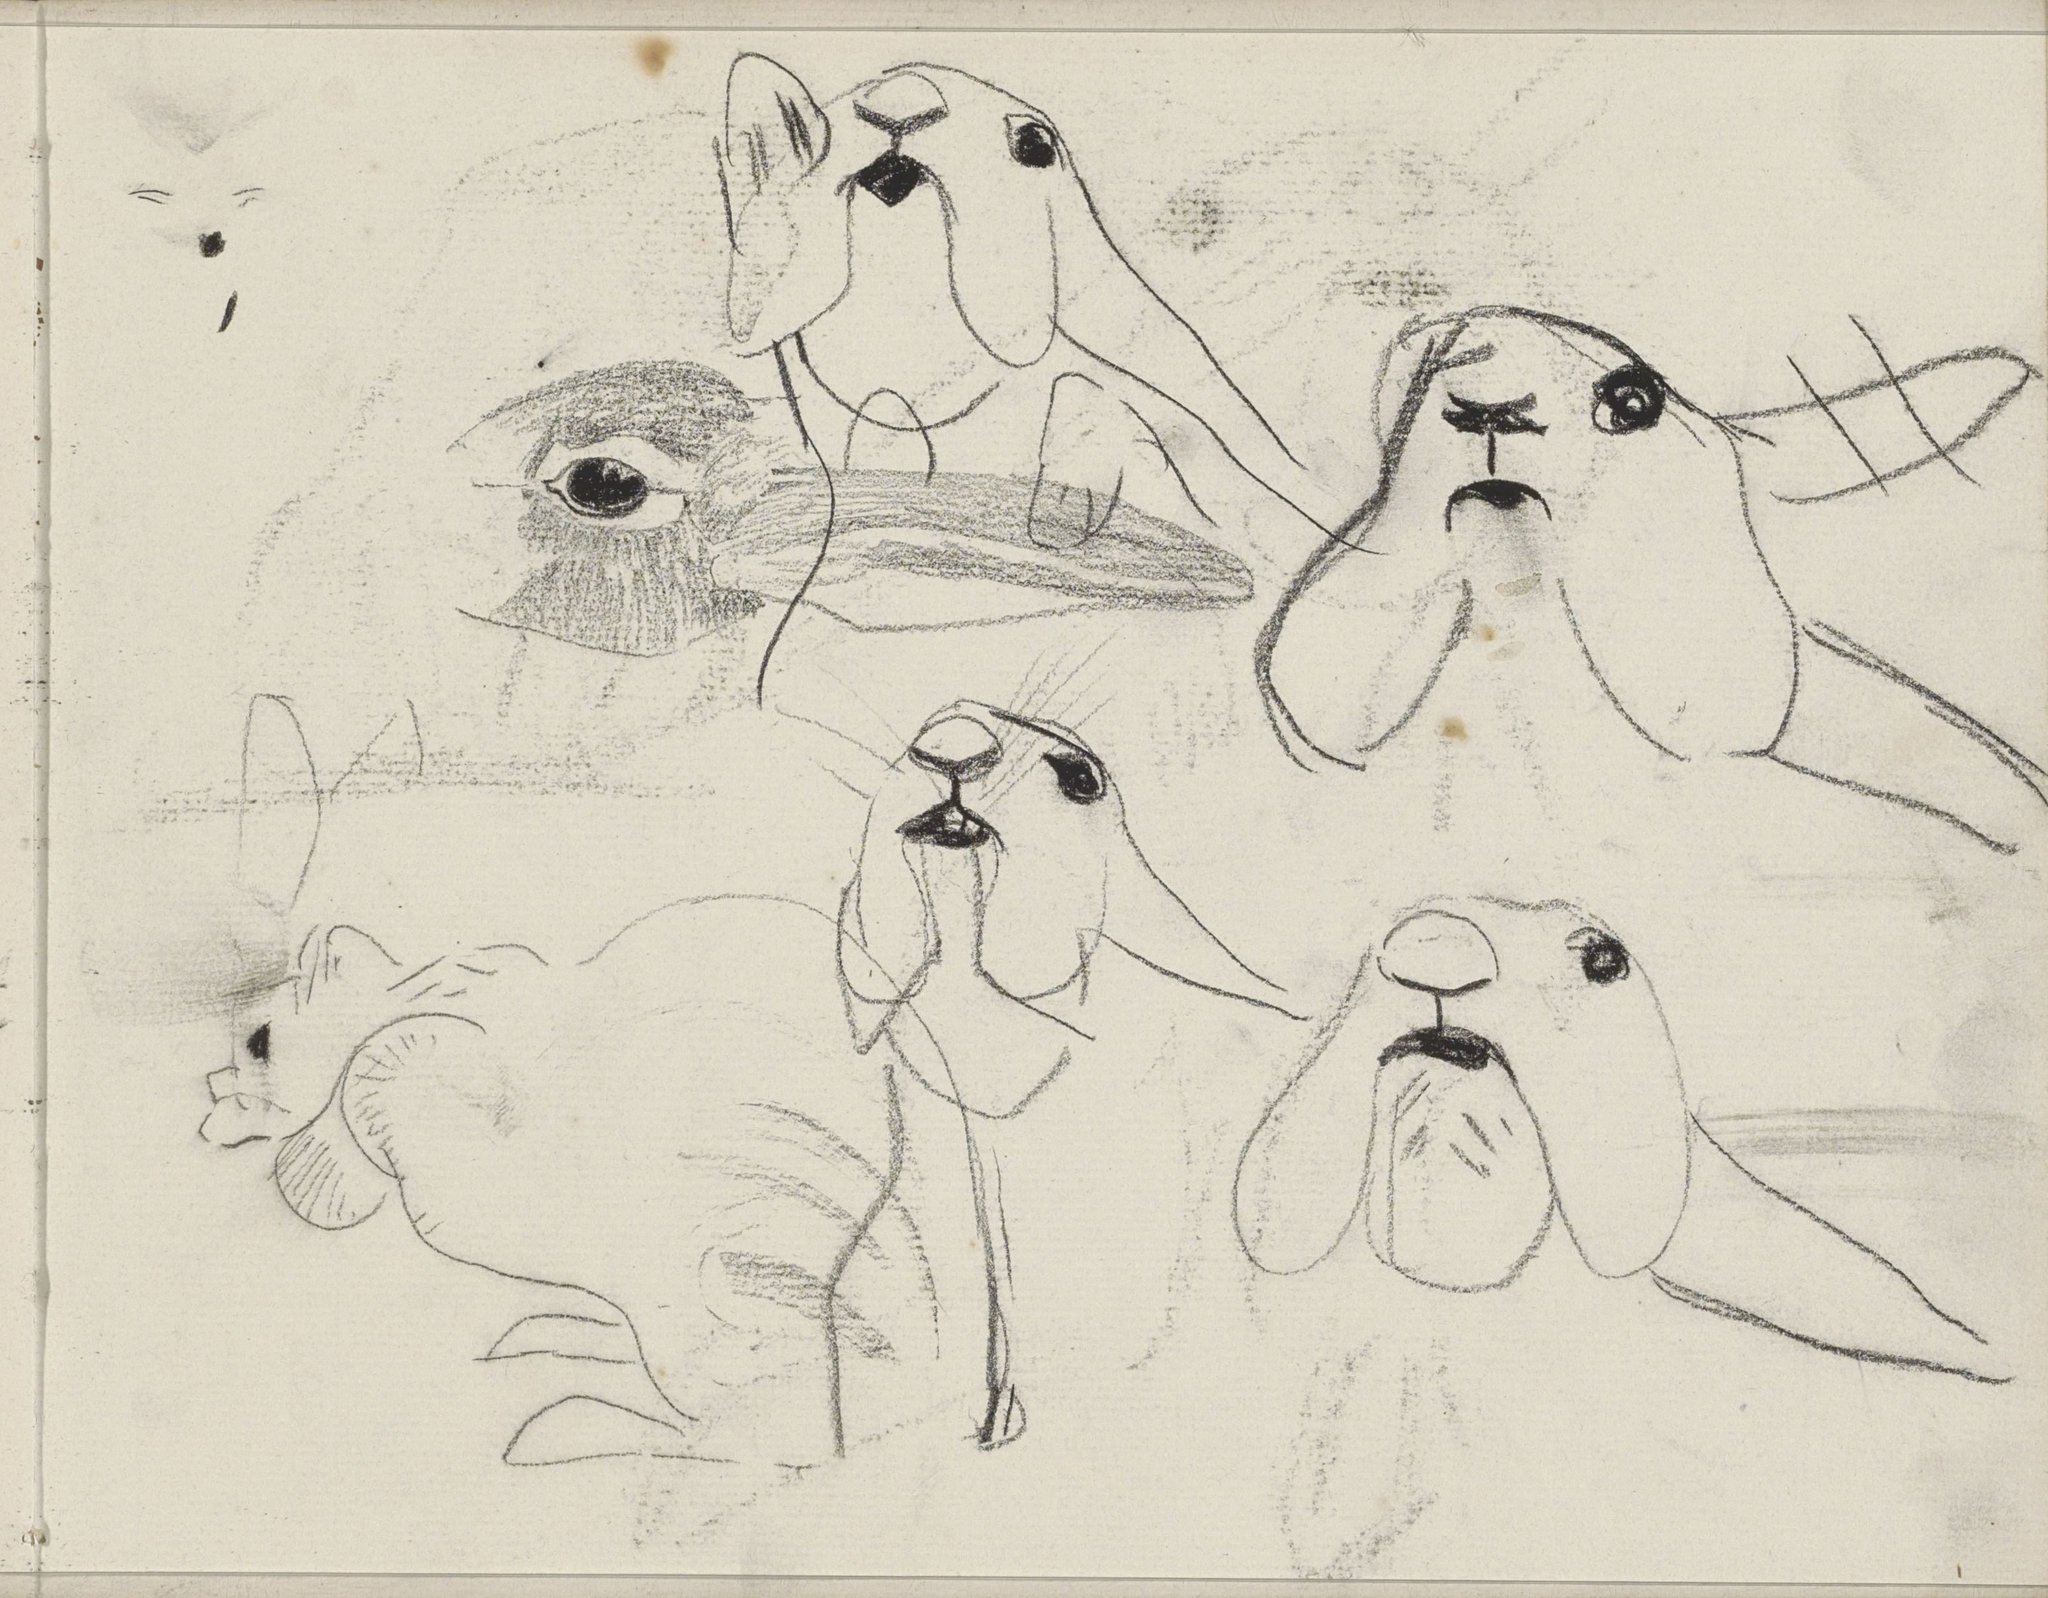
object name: sketchbook leaf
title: Konijnen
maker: carel adolph lion cachet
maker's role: draughtsman, print maker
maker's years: 1864-1945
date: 1896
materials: chalk, paper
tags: rodents: rabbit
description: Blad 21 recto uit een schetsboek met 44 bladen.